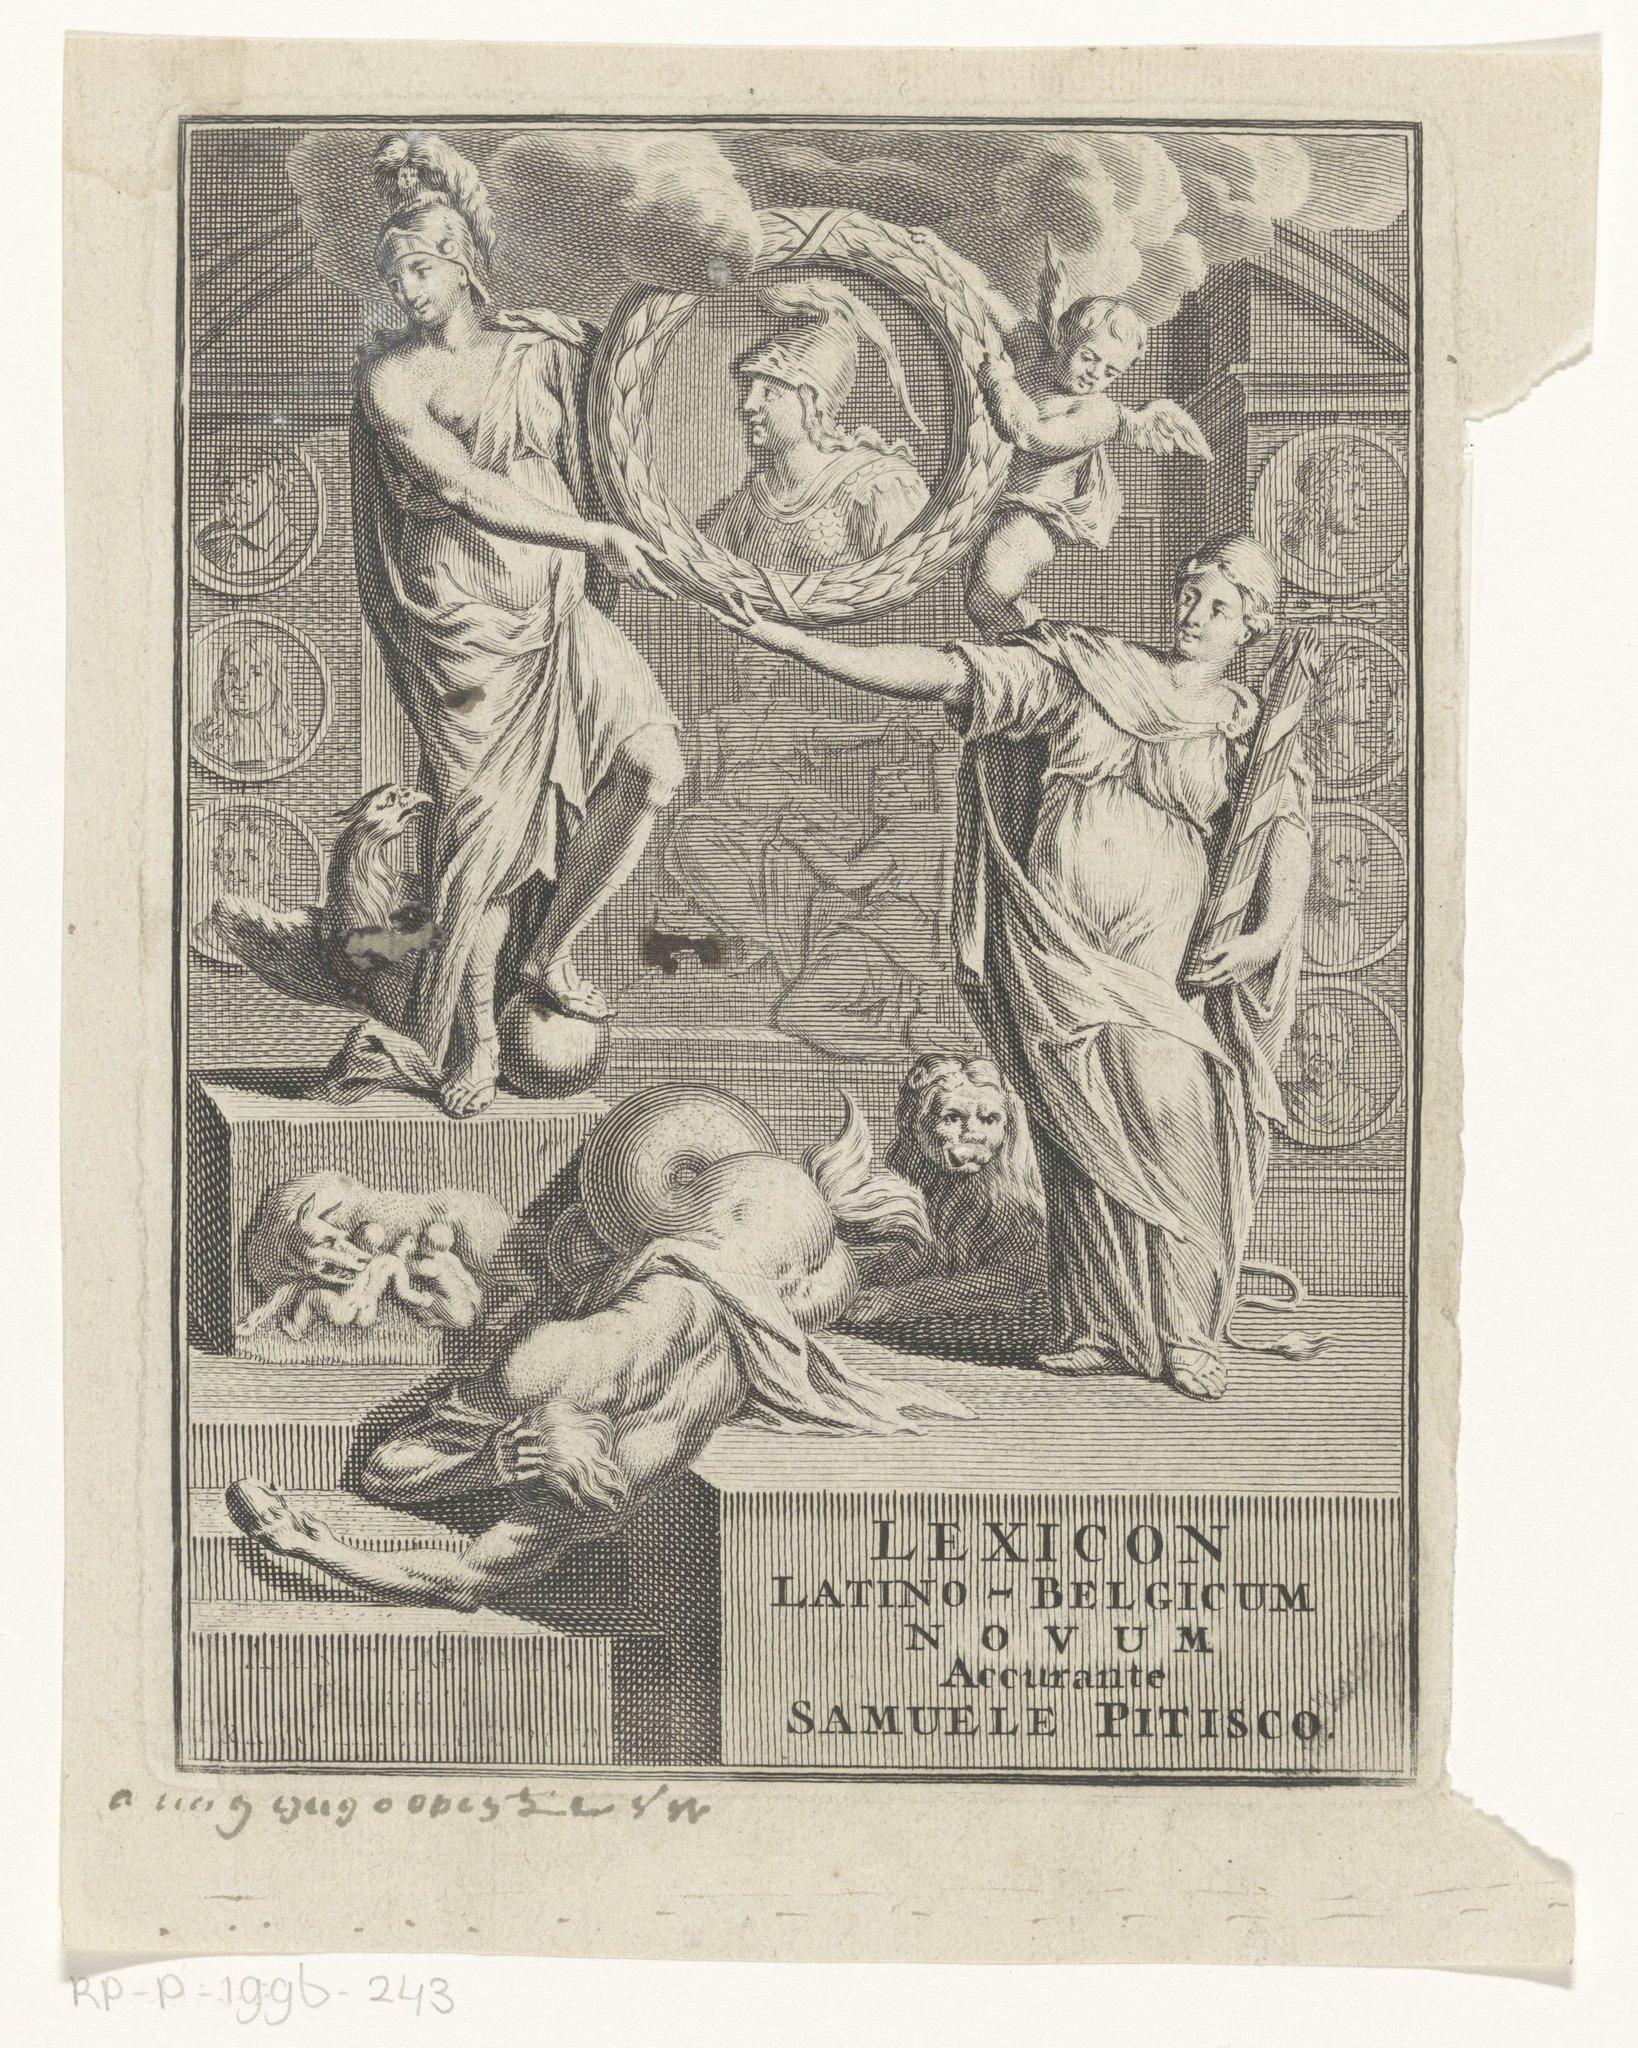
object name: print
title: Titelpagina voor: Samuel Pitiscus, Lexicon Latino-Belgicum novum, s.a.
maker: Anonymous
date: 1725-1754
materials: paper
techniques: engraving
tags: personifications of countries, nations, states, districts, etc., (story of) minerva (pallas, athena), low countries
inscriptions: collector's mark: Lugt 2760, collector's mark: Lugt 2228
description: De personificatie van de Nederlanden met pijlenbundel en een leeuw en de personificatie van het Romeinse Rijk met een adelaar, een globe en de afbeelding van de wolvin met Romulus en Remus, houden een portret van Minerva in lauwerkrans omhoog. Een meerman valt neer bij hun voeten. Op de muur achter hen portretten in medaillons van figuren uit de oudheid en eigen tijd.